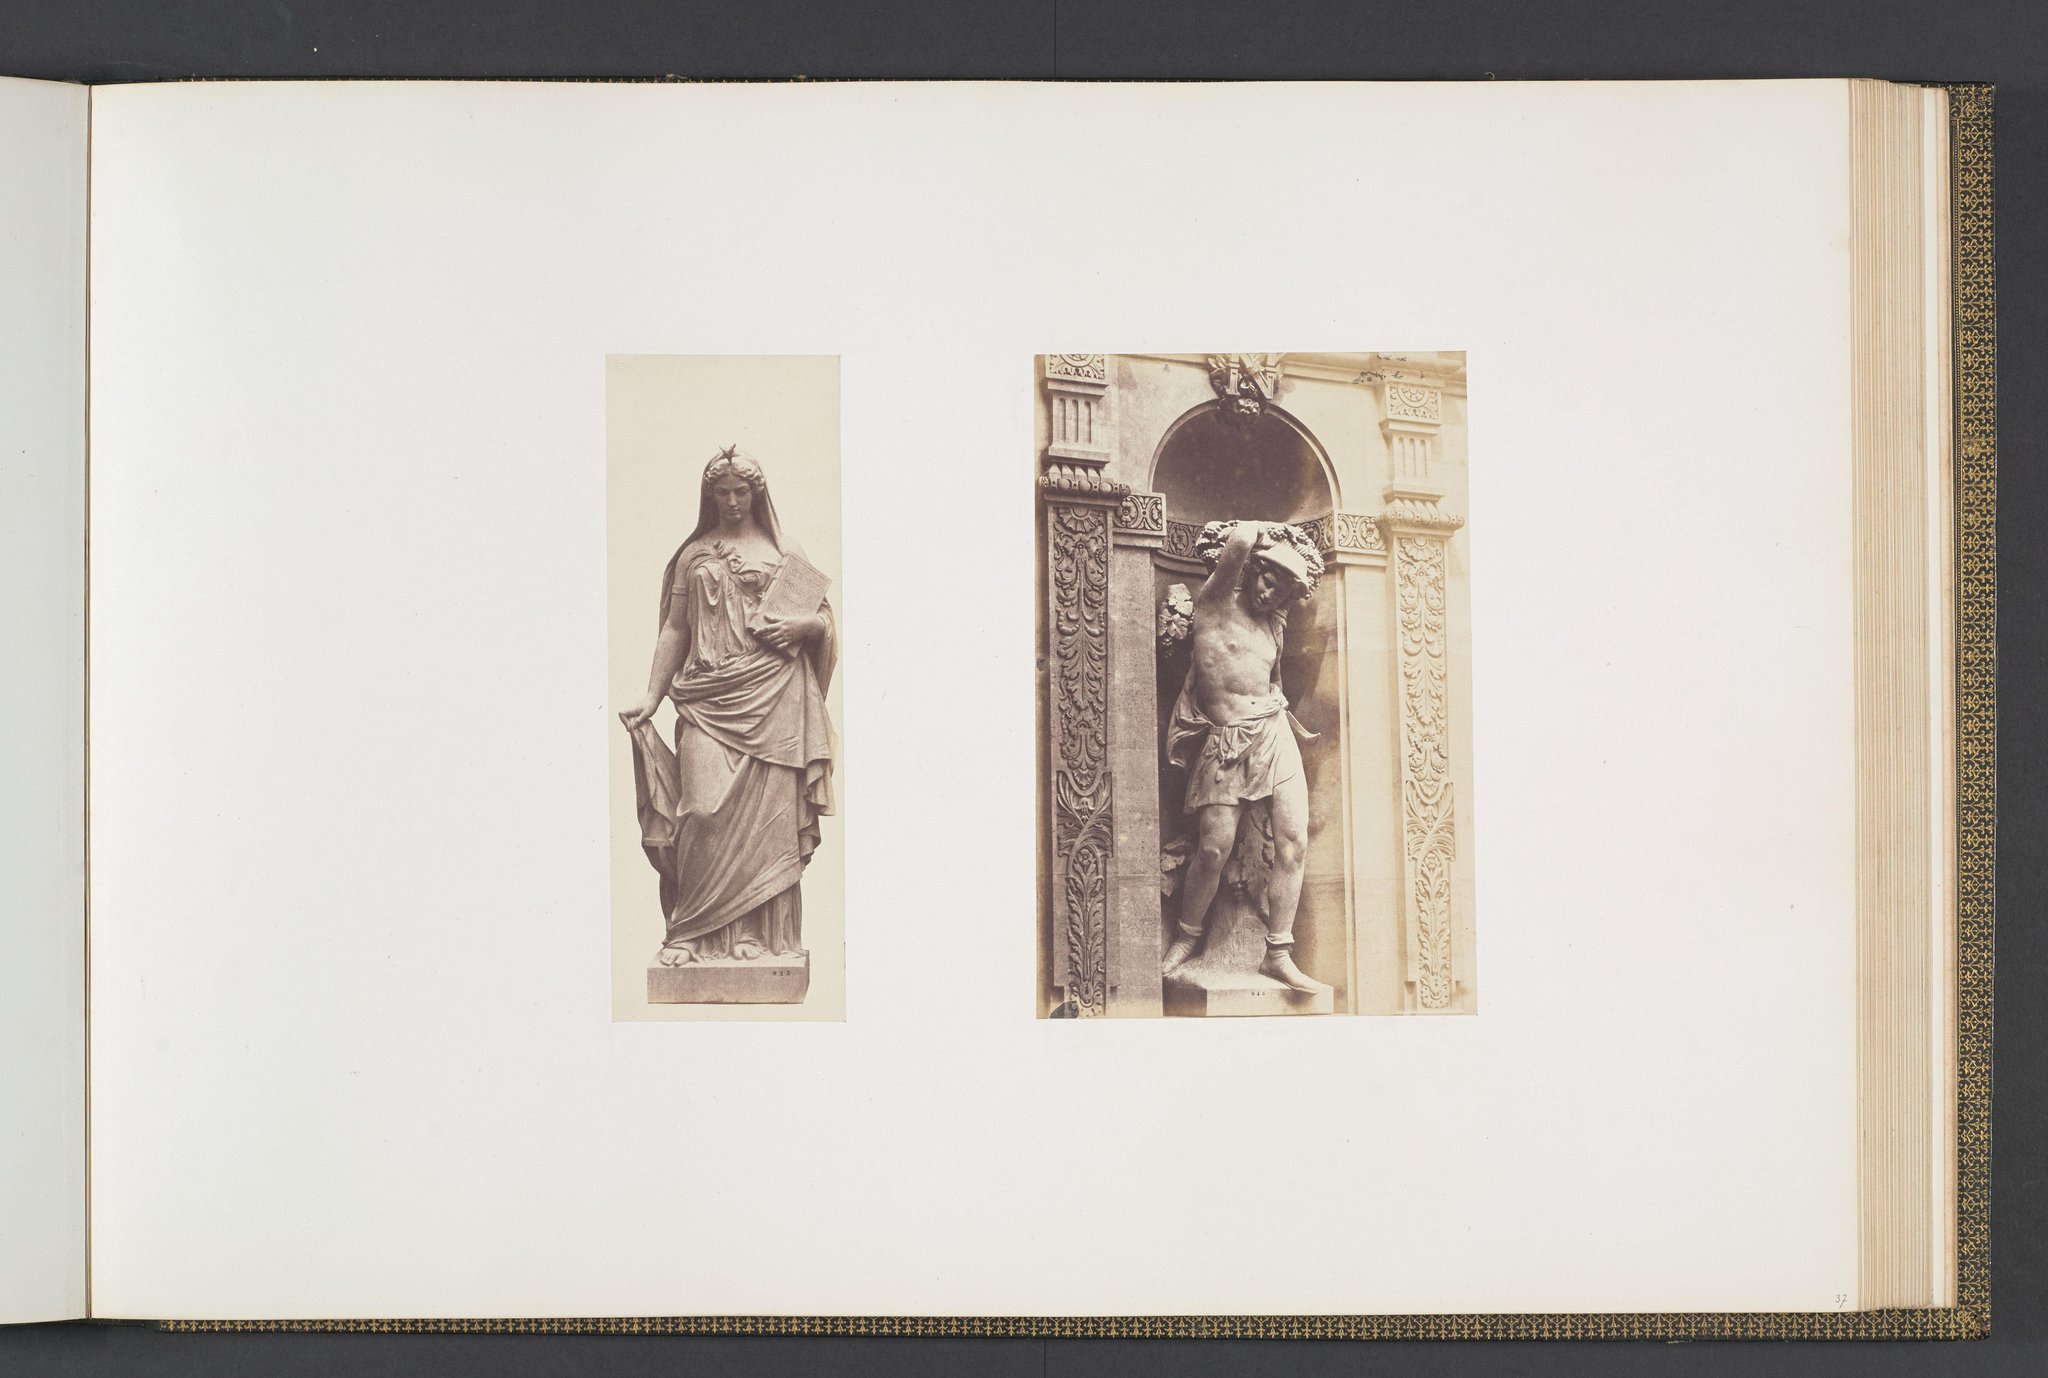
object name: photograph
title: Gipsmodellen voor beeldhouwwerken op het Palais du Louvre: links "La Science" door Jacques Maillet en rechts "Le Vendangeur" door Paul Cabet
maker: édouard denis baldus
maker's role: fotograaf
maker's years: 1813-1889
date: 1855-1857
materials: paper, photographic support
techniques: salted paper print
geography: paris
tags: piece of sculpture, reproduction of a piece of sculpture, permanent exhibition, museum, paris, tuileries palace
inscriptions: number: ‘923 en 948’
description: Onderdeel van Réunion des Tuileries au Louvre 1852-1857, album 3.